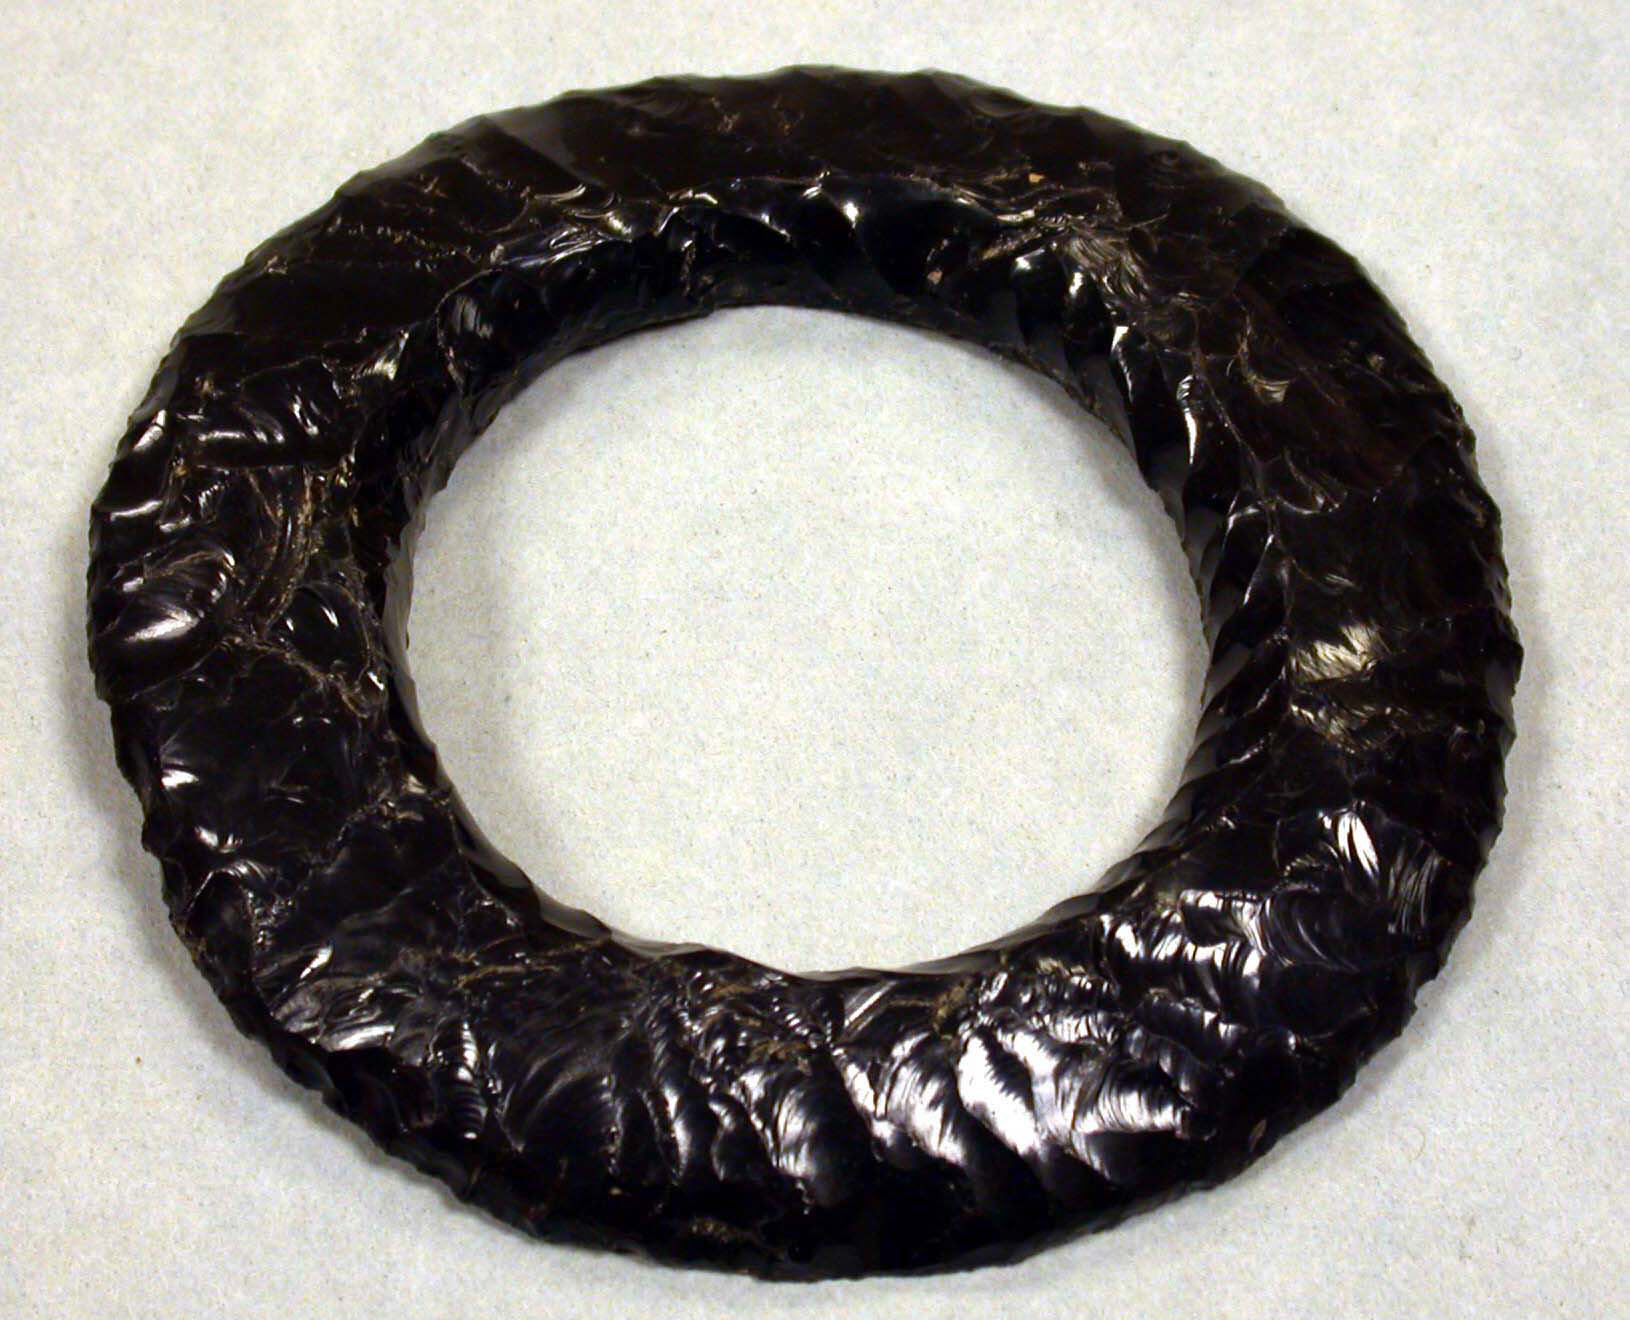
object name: knife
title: Eccentric Blade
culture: mexican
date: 1501-1600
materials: obsidian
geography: mexico